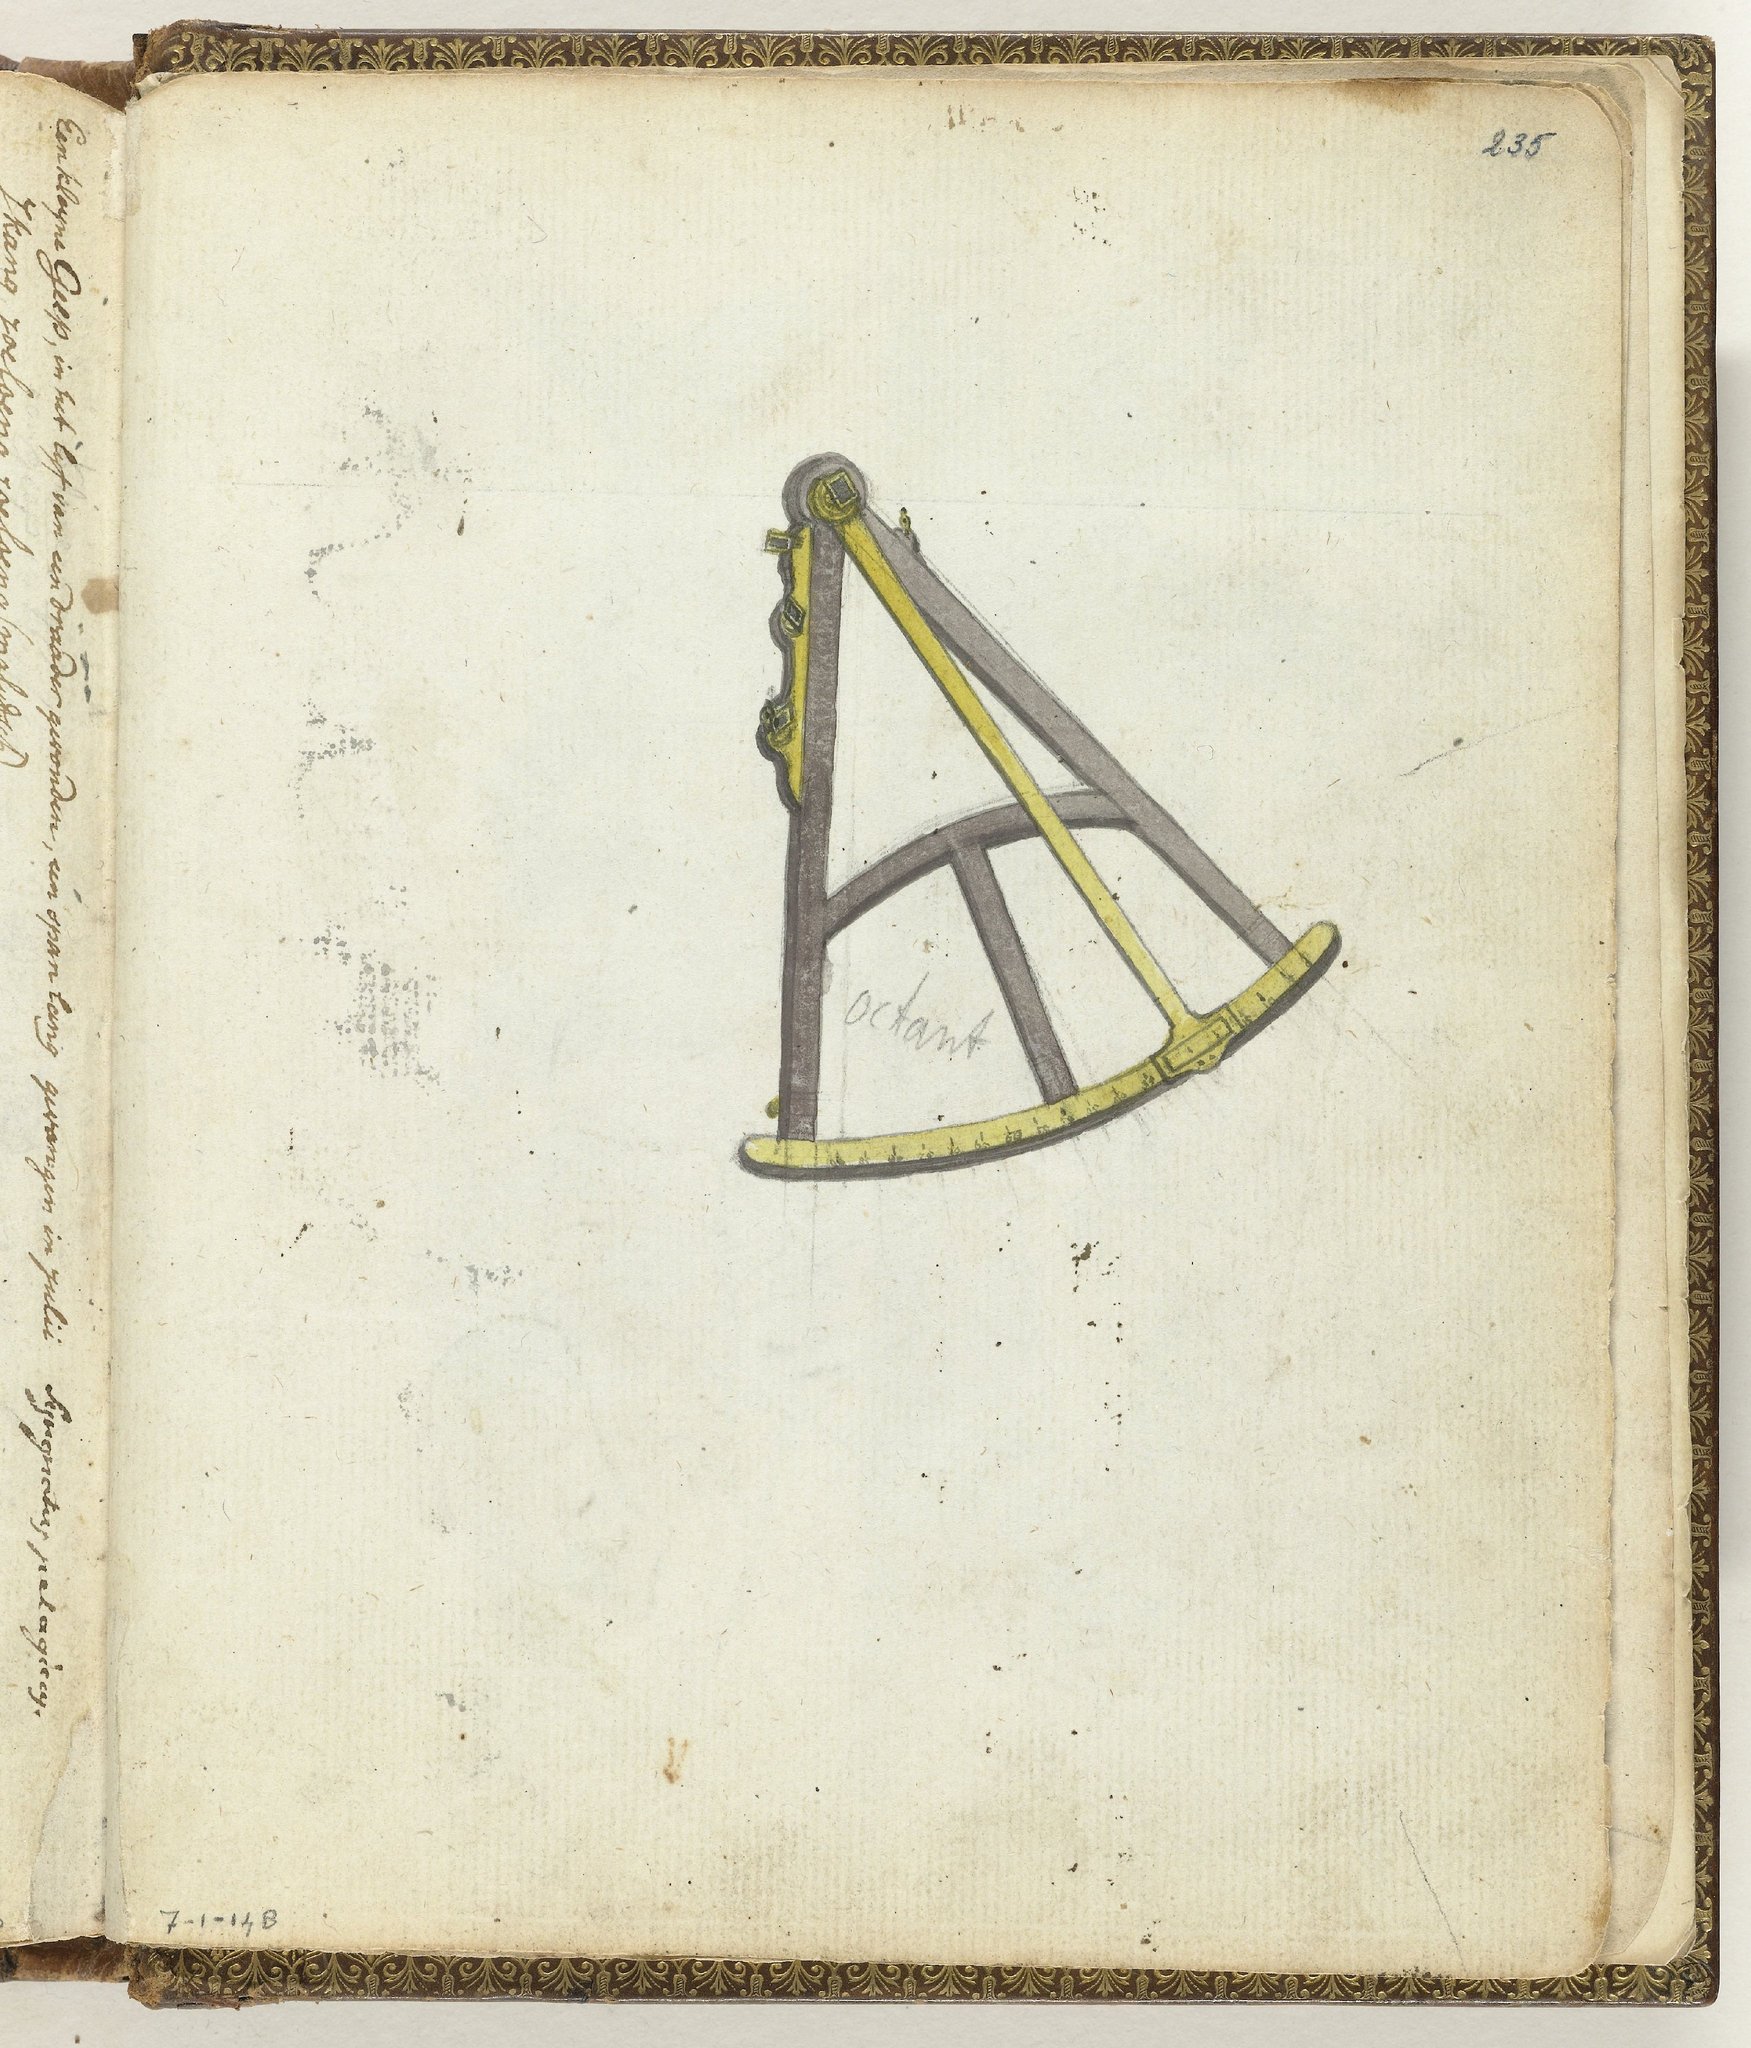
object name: drawing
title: Octant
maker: jan brandes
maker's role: draughtsman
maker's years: 1743-1808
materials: paper, pencil, watercolor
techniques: brush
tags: quadrant, sextant, octant (nautical instruments)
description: Kleurtekening van een octant. Met opschrift. Onderdeel uit het schetsboek van Jan Brandes, dl. 1 (1808), p. 235.